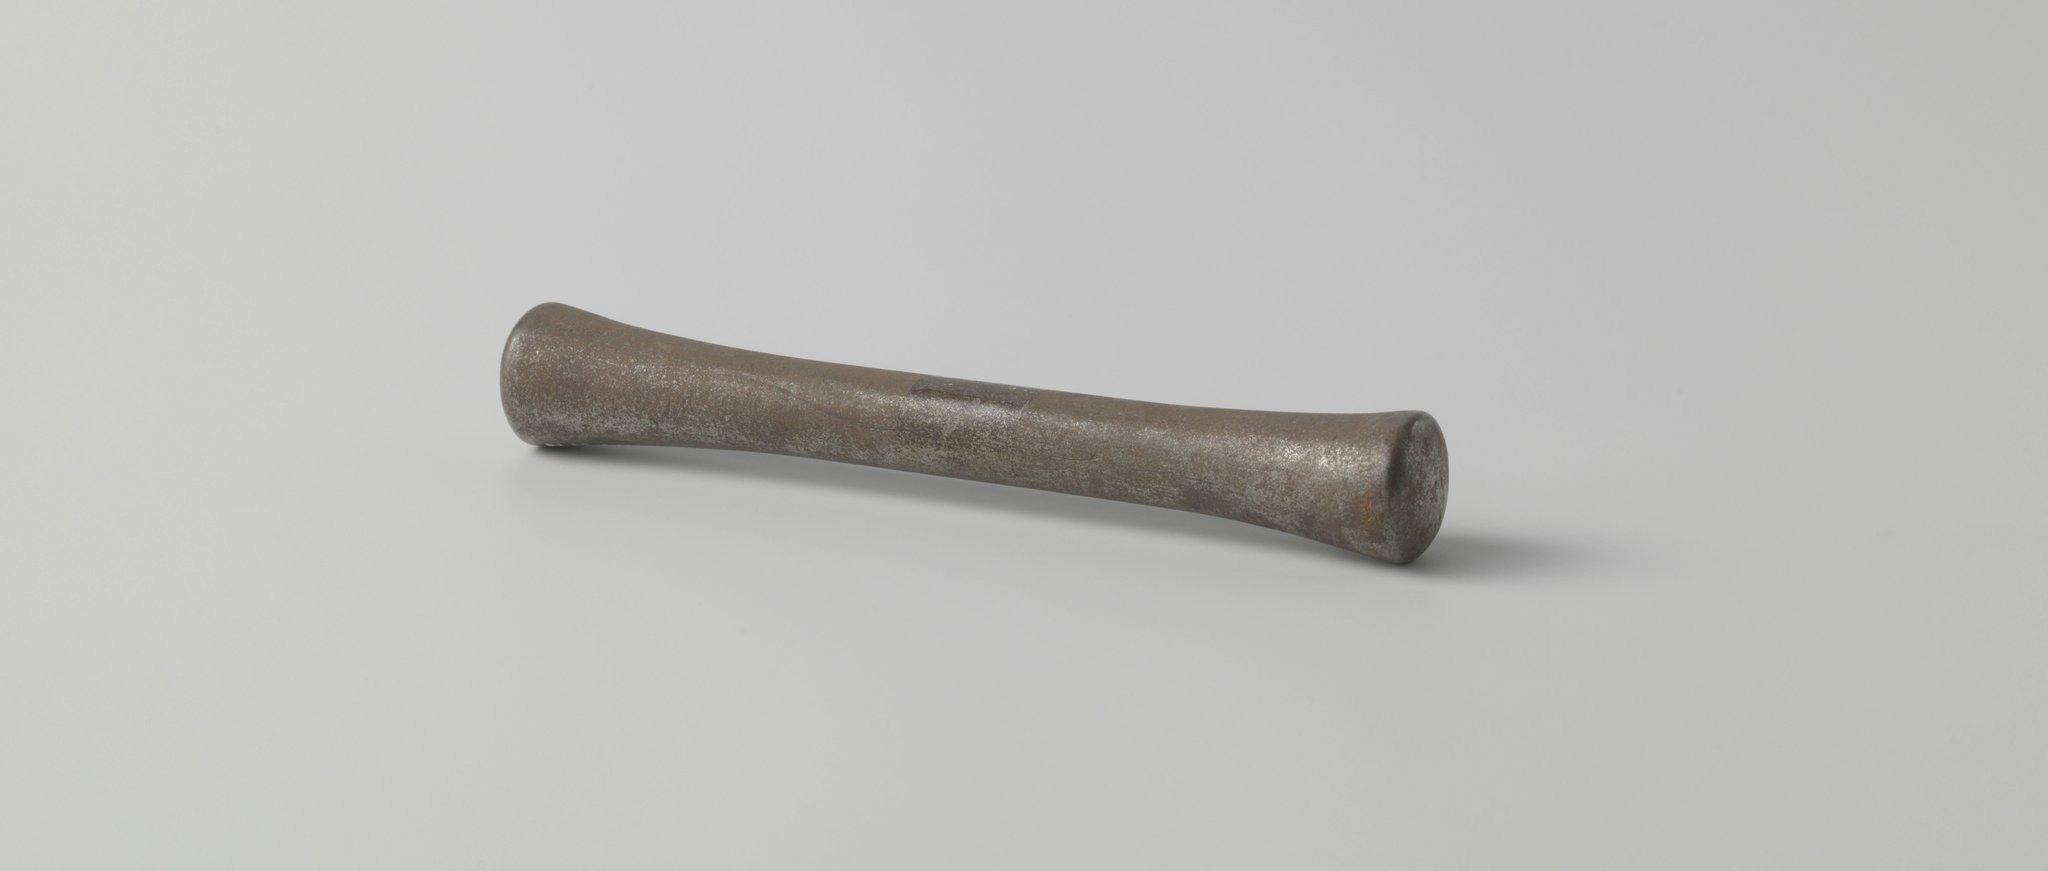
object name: beater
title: Stamper van gietijzer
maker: jan van den ghein (ii)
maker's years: 1520-1573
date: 1553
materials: iron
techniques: casting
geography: mechelen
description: De gegoten ronde vijzel verbreedt zich naar boven toe en heeft een hoge uitkragende geprofileerde rand en een geprofileerde voet. Op de rand in Latijnse majuskels het oposchrift IAN VANDEN GHEIN ME FECTI MCCCCCLIII met één interpunctie in de vorm van een vierbladig roosje. Om het midden van de wand een fries met een ramskop tussen twee maskers en een door twee griffioenen opgehouden vaas (drie en half maal herhaald).